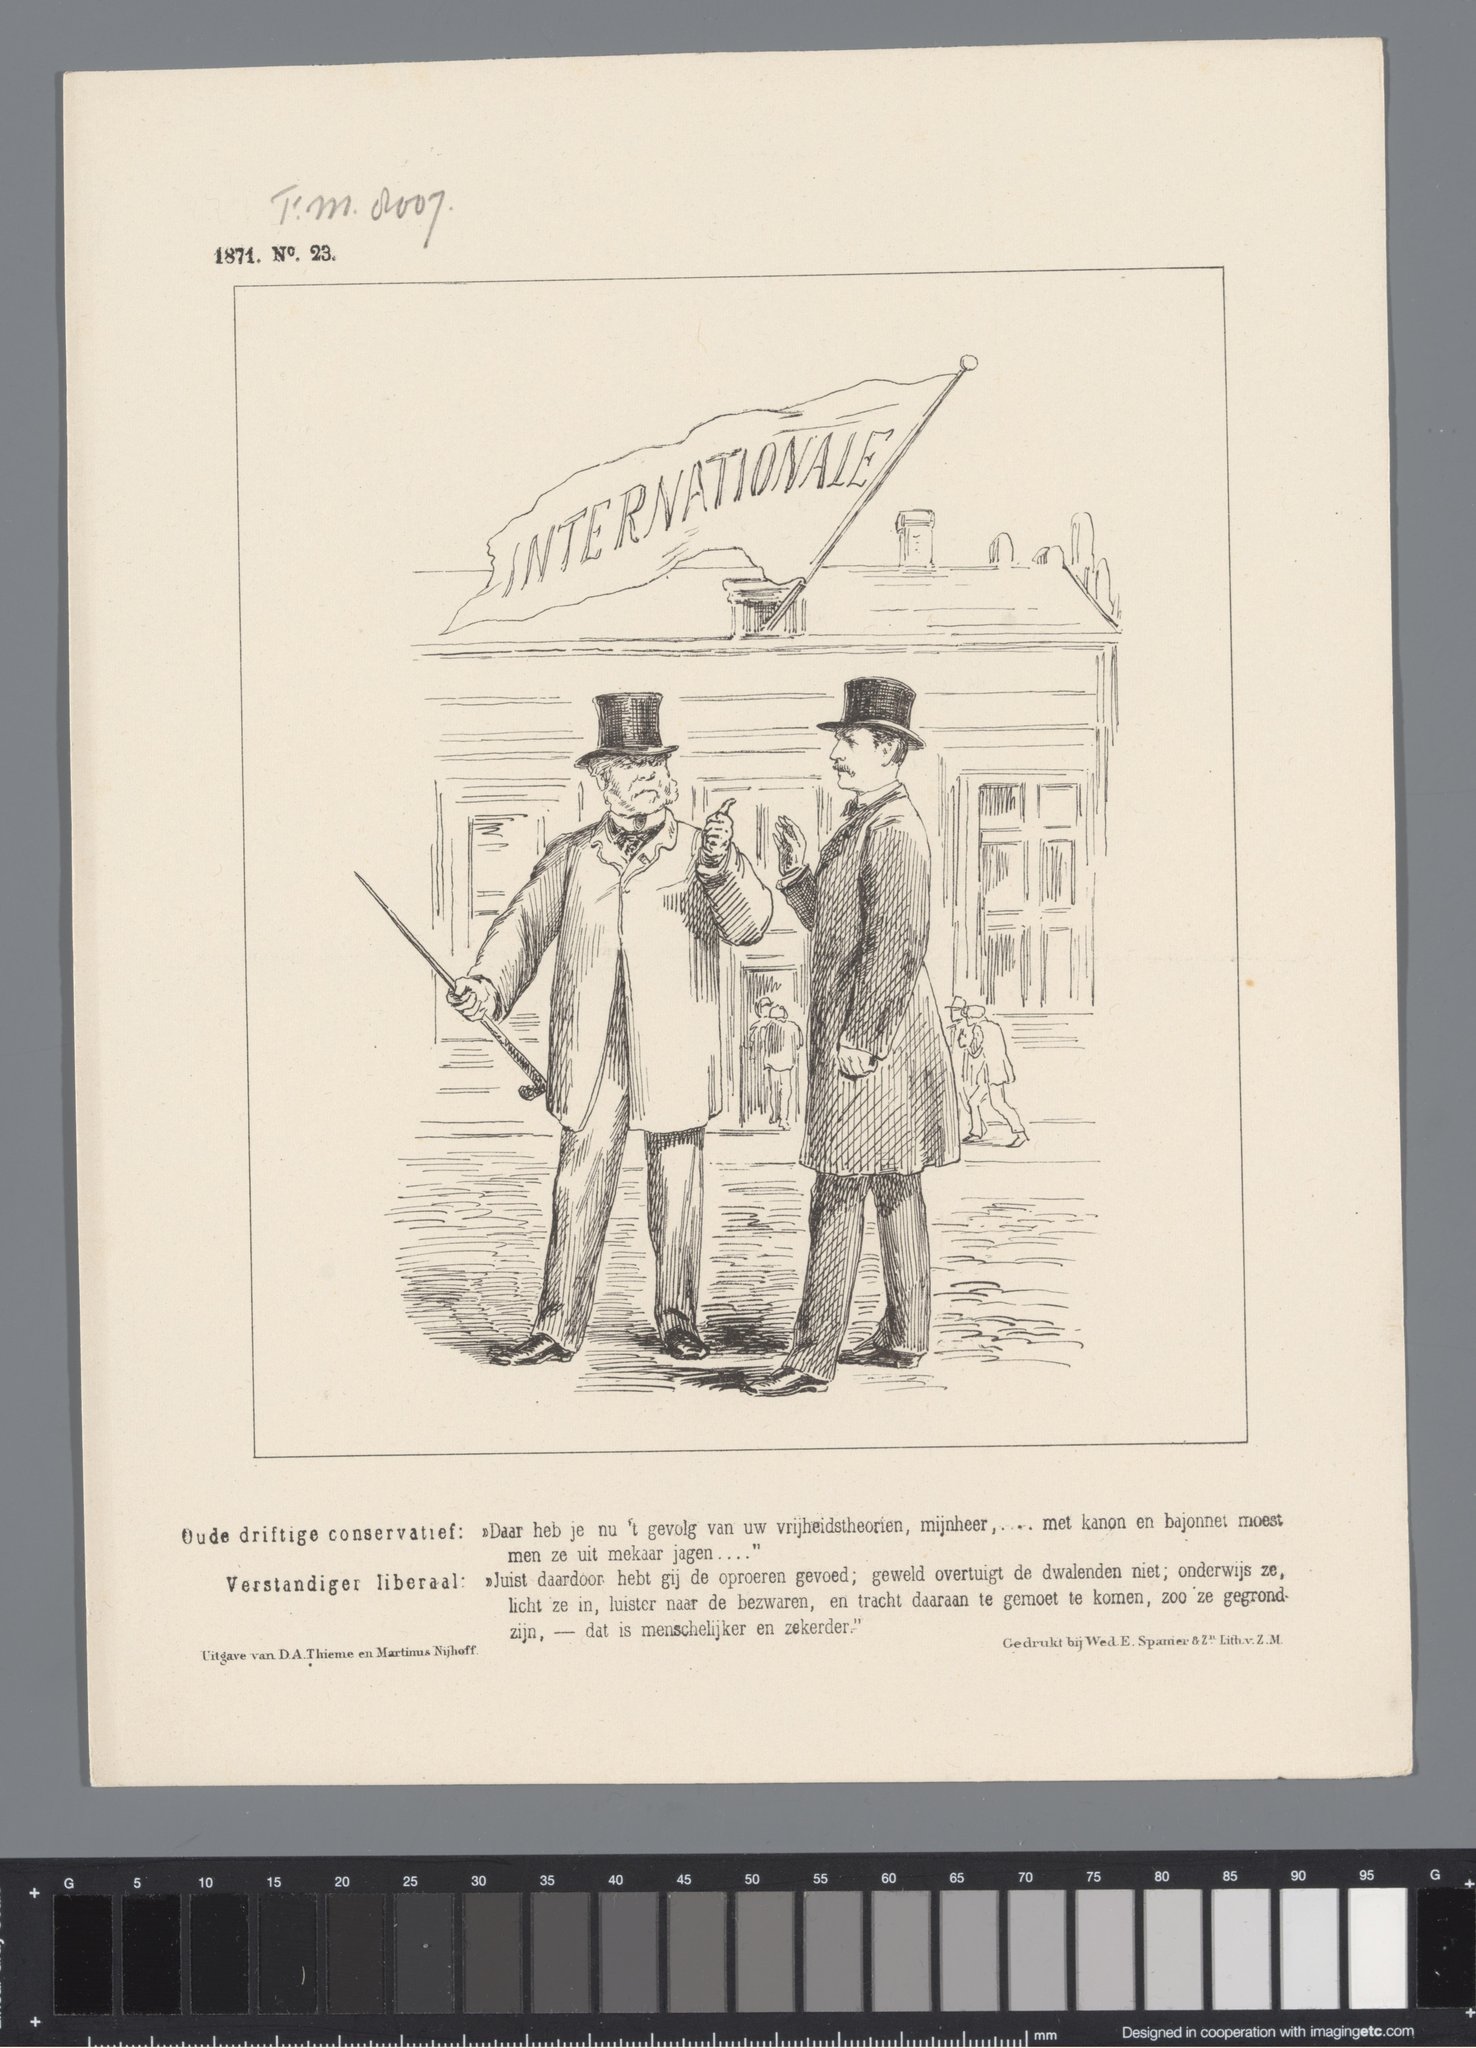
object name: print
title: Spotprent op het Congres der Internationale, 1871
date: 1871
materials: paper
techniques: lithograph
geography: netherlands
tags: meeting, assembly, political meeting, propaganda meeting, the hague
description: Spotprent op het Congres der Internationale te Den Haag. Een conservatief en een liberaal spreken met elkaar over het congres. Plaat verschenen bij het weekblad De Nederlandsche Spectator, nr. 23, 1871.